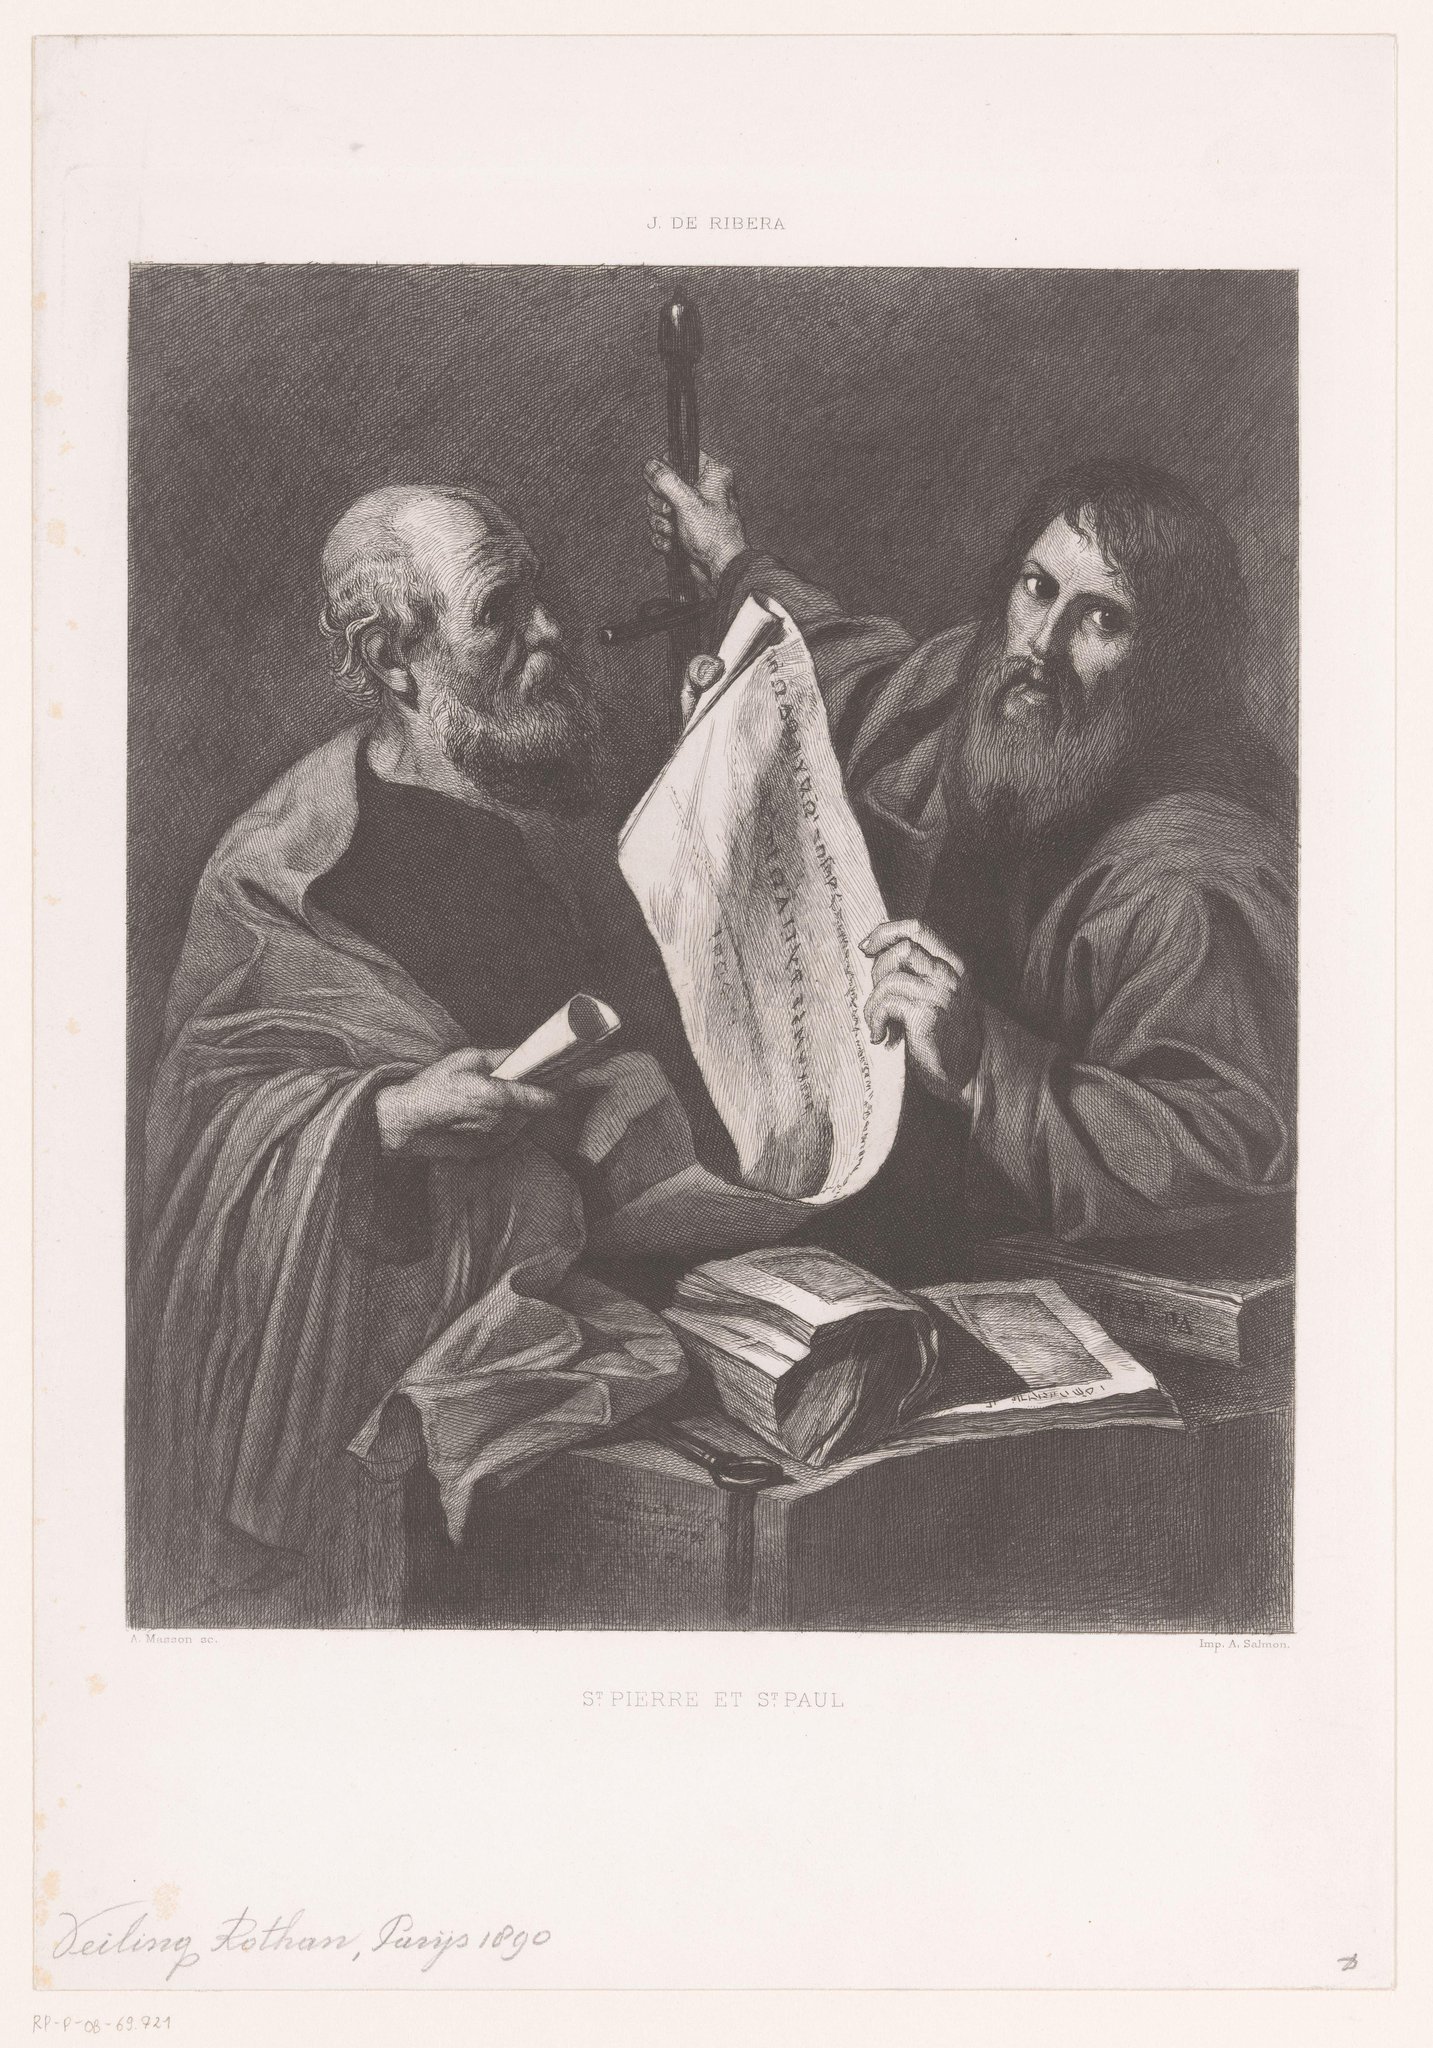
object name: print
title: H. Petrus en H. Paulus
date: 1824-1898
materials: paper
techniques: engraving, etching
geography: paris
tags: the apostle peter, first bishop of rome; possible attributes: book, cock, (upturned) cross, (triple) crozier, fish, key, scroll, ship, tiara, the apostle paul of tarsus; possible attributes: book, scroll, sword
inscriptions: collector's mark: Lugt 2228